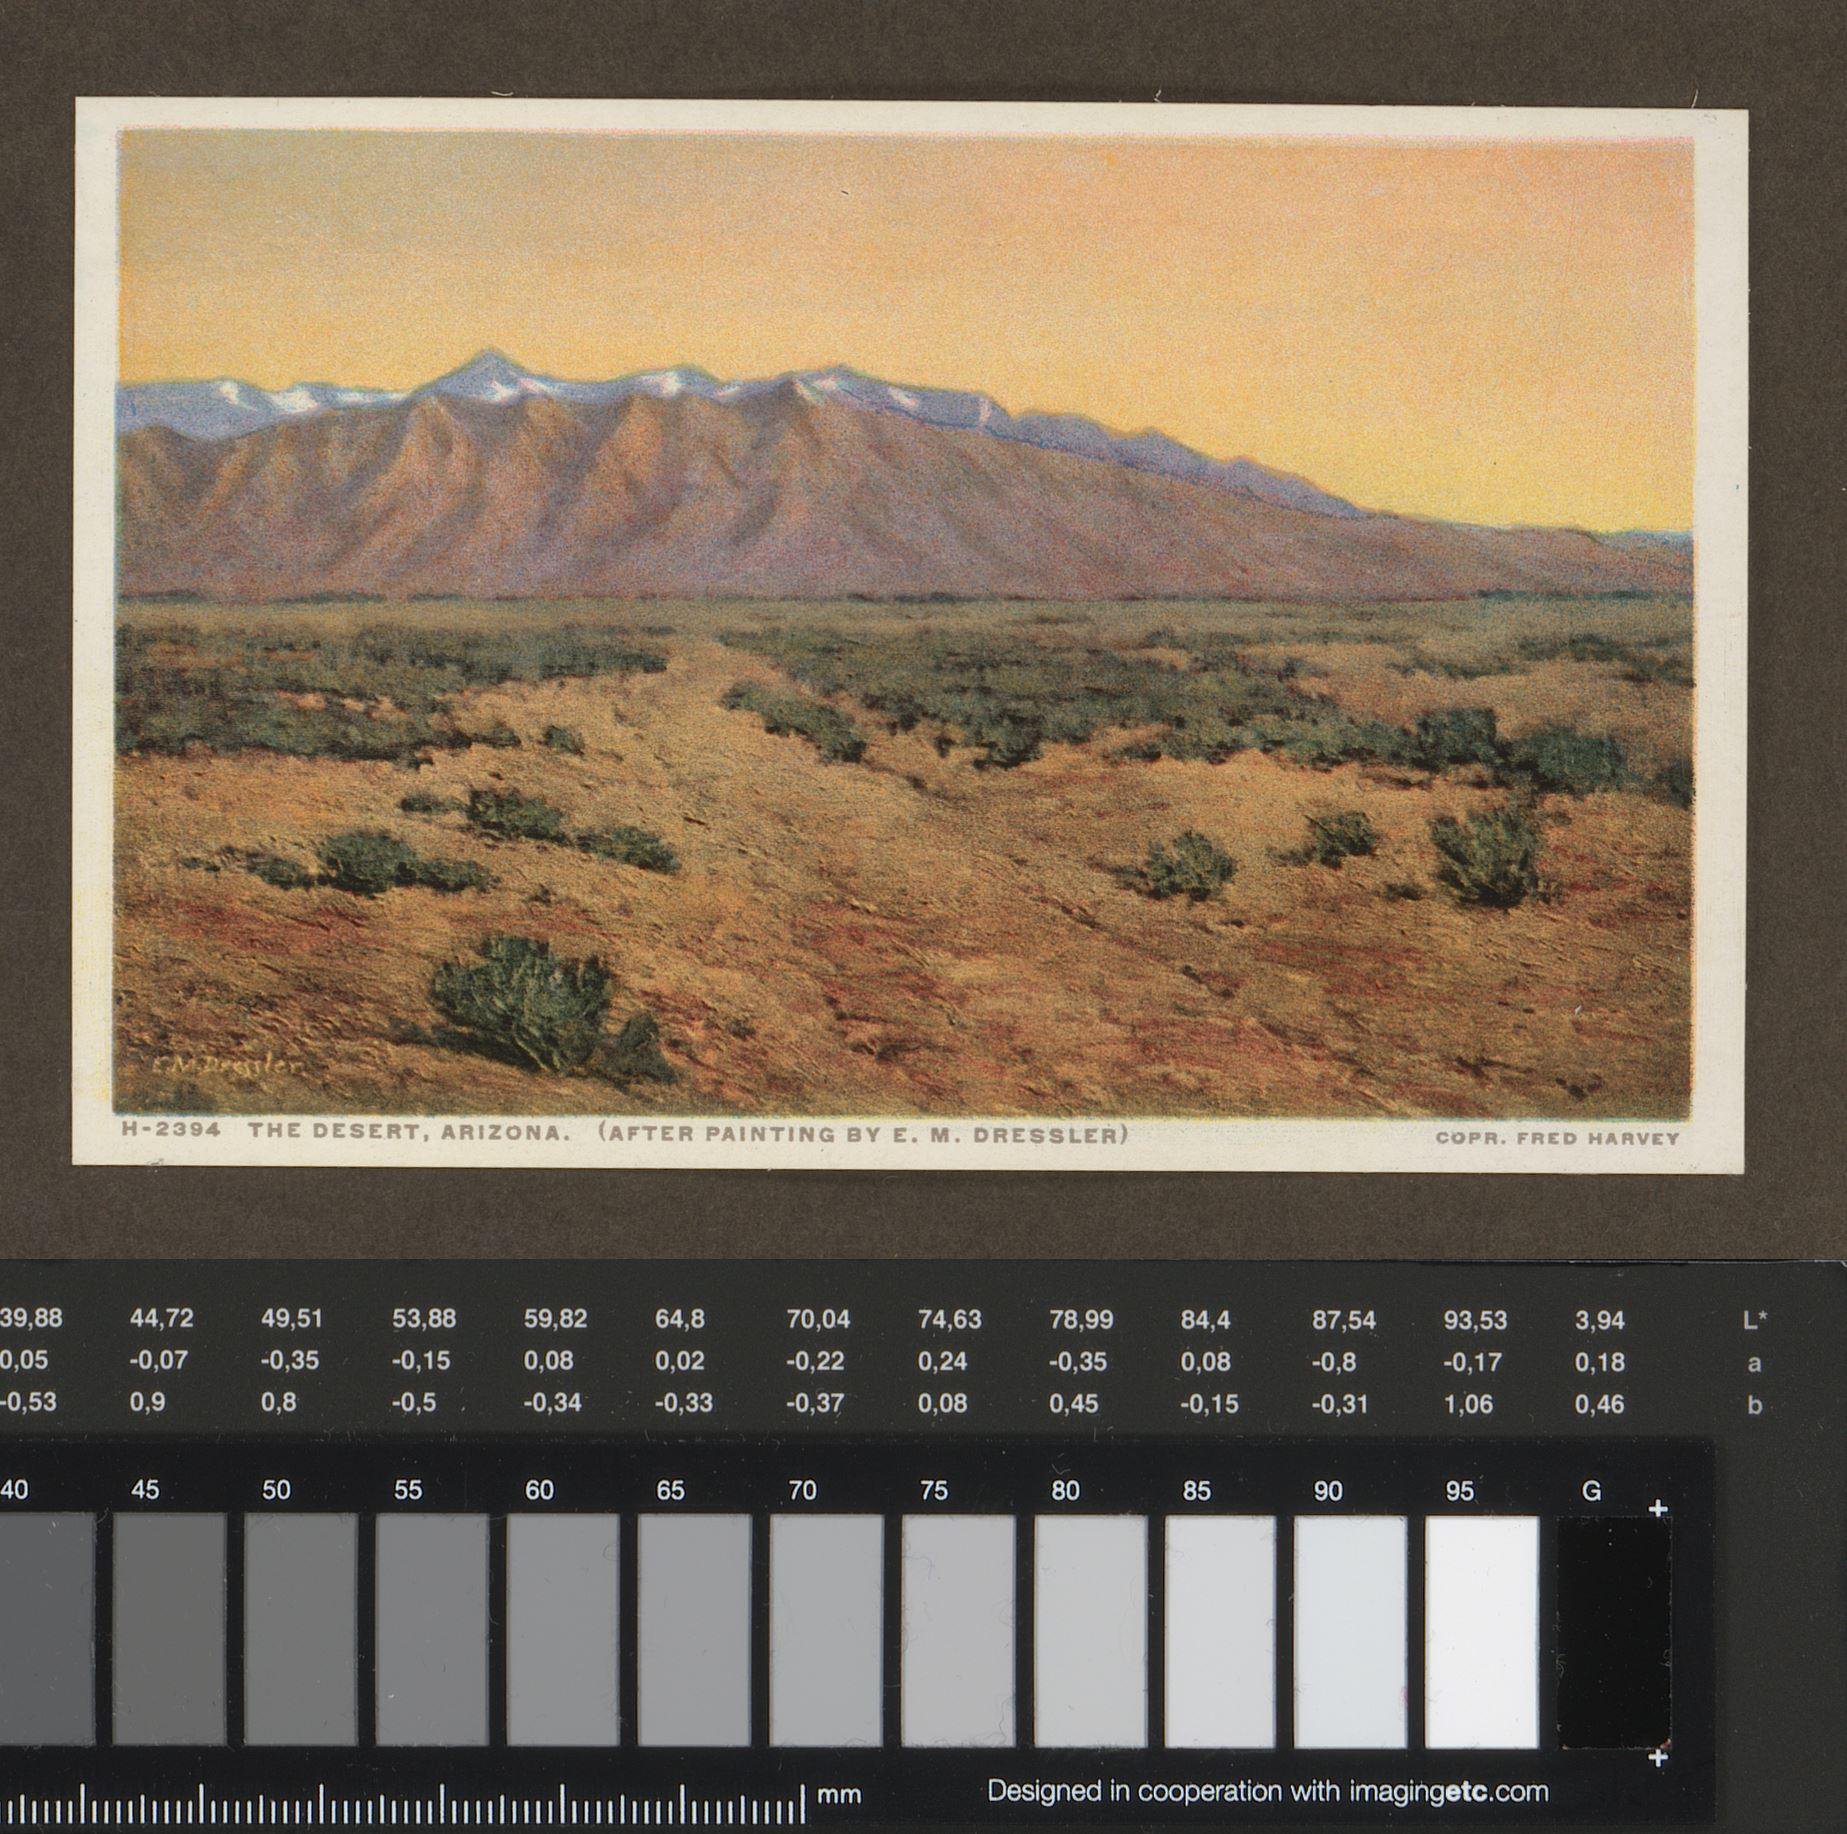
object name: ansichtkaart, prentbriefkaart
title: The desert, Arizona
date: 1928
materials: paper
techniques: chromolithography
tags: desert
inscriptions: inscription: ‘(after painting by E. M. Dressler) Copr. Fred Harvey’, number: ‘H-2394’